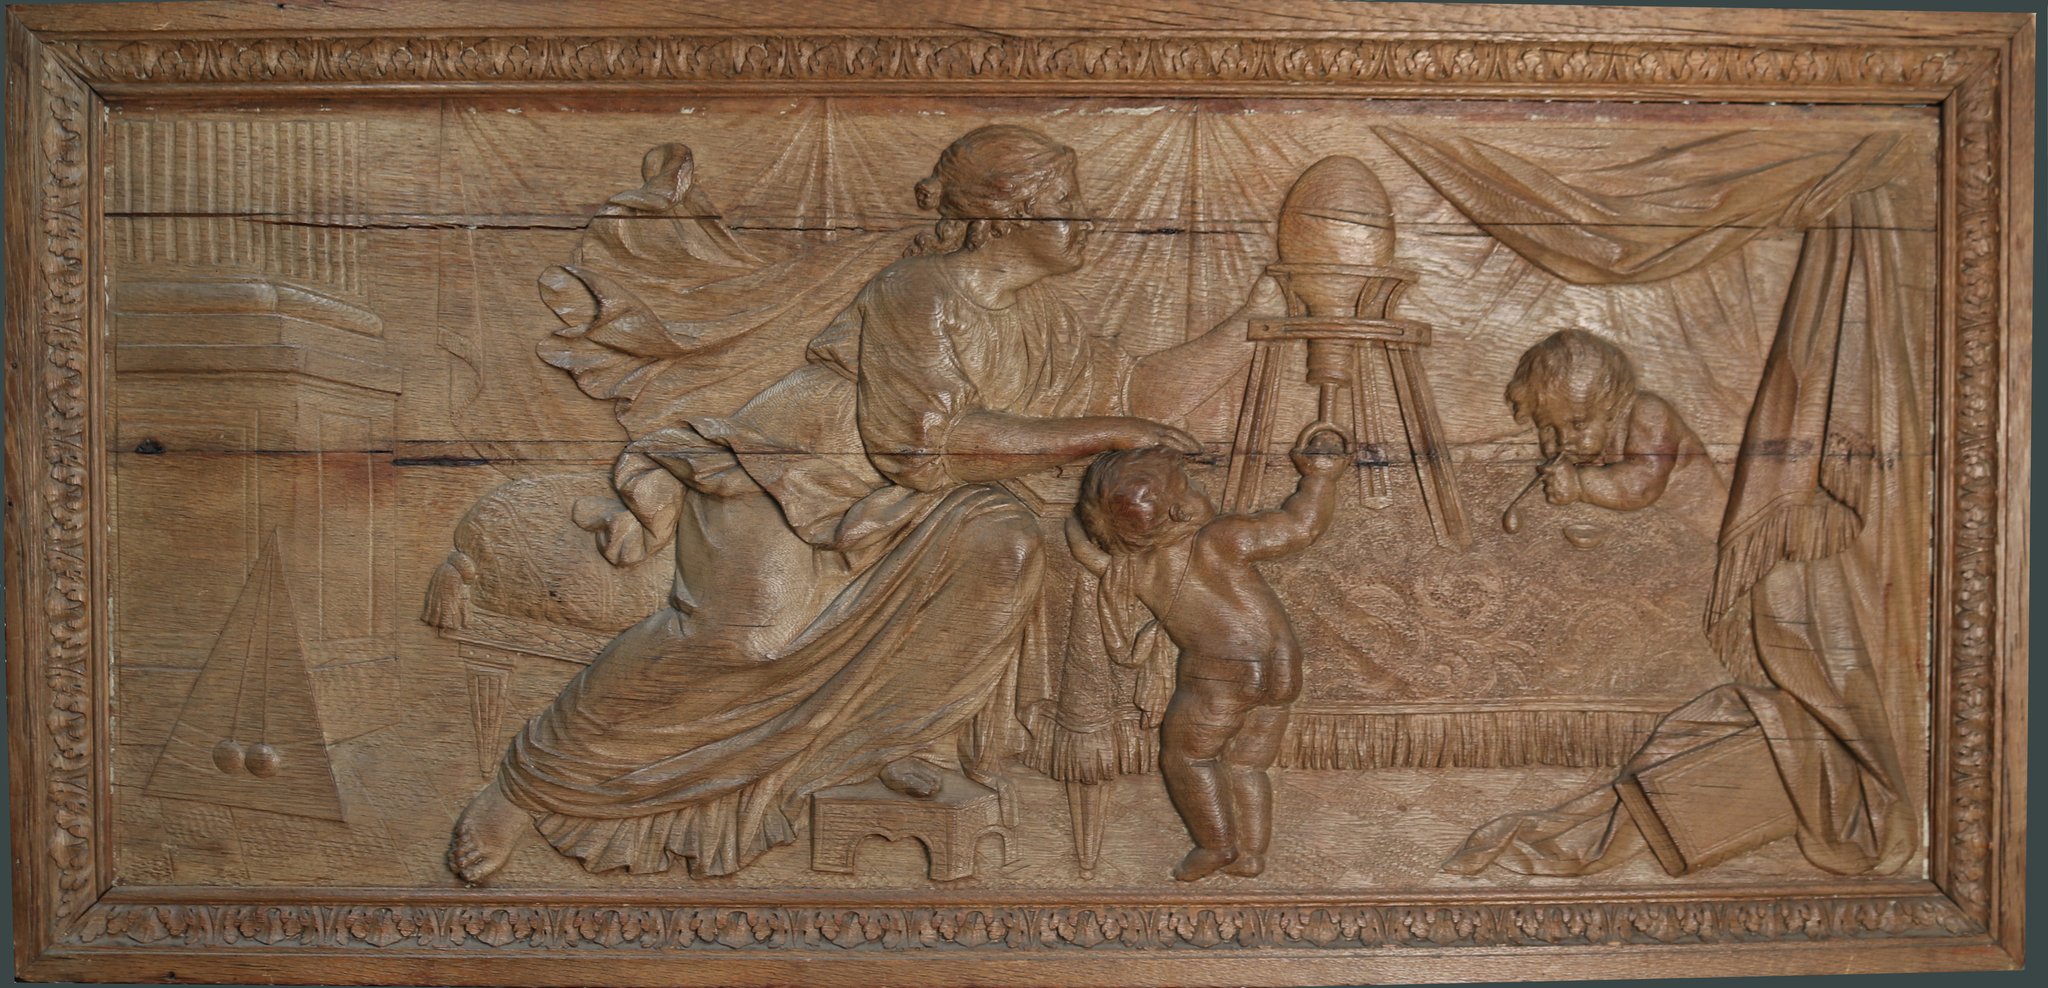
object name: overdoor panel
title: Overdoor panel with allegory of Science (one of a pair)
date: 1701-1800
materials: wood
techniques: polish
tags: women,putti,scales